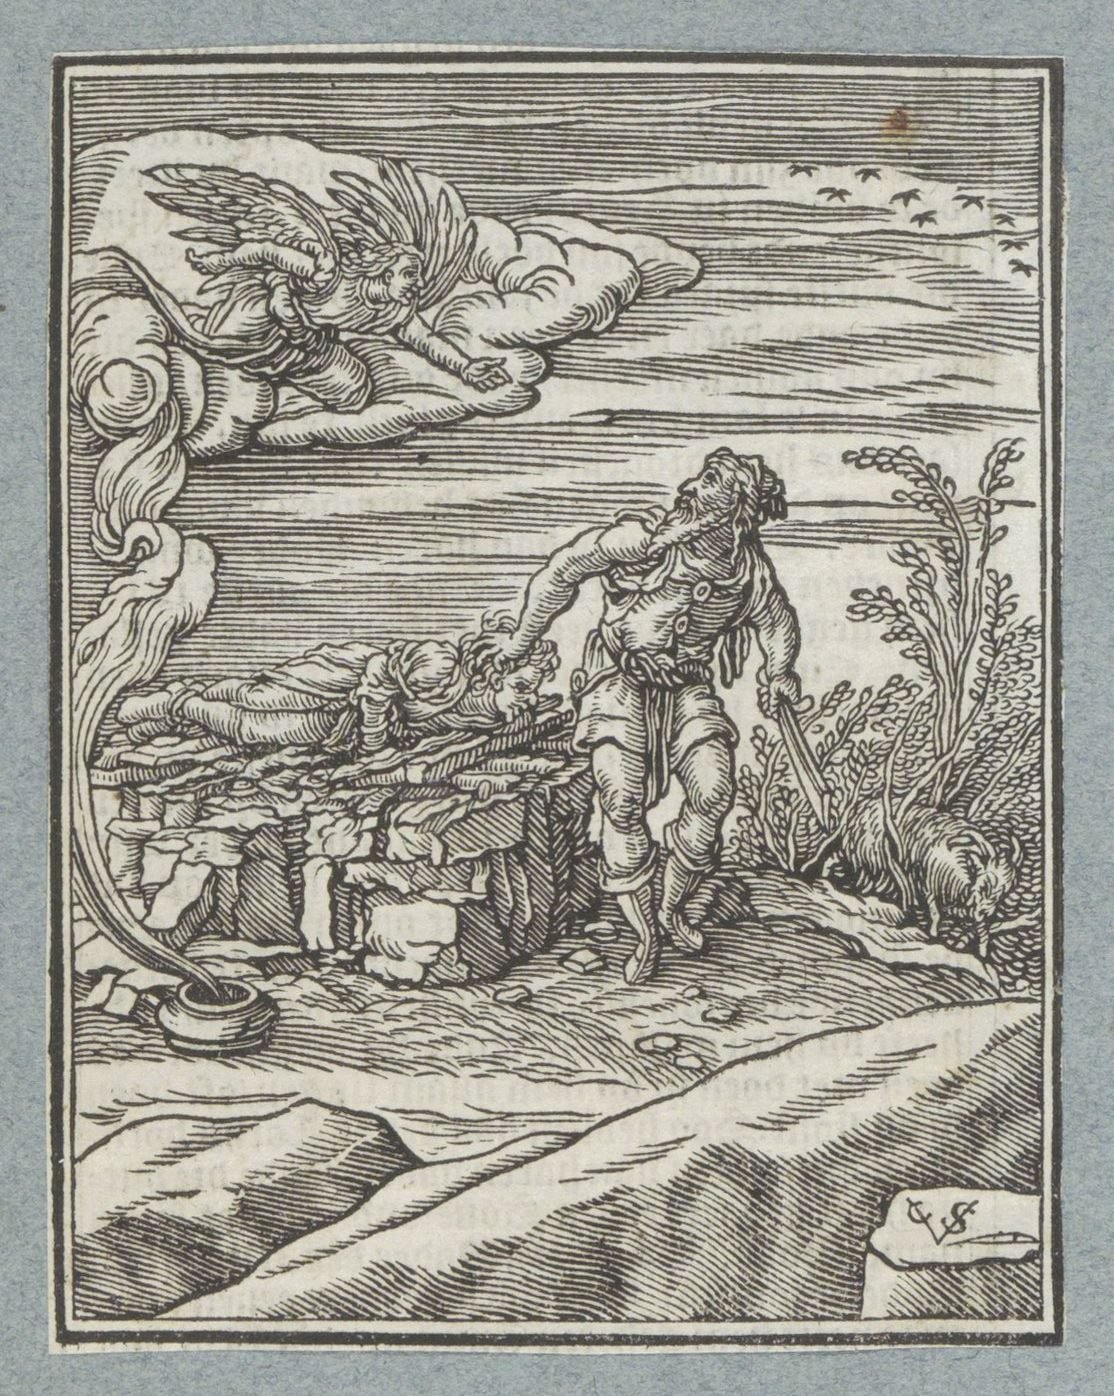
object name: book illustration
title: Offer van Abraham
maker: pieter jacobsz. paets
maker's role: publisher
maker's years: 1587-1667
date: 1645-1646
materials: paper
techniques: letterpress printing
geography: amsterdam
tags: abraham picks up the knife to kill isaac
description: De prent werd gemaakt voor de uitgaven van P.J. Paets uit Amsterdam. Ze komt in ieder geval voor in: Bibels Tresoor ofte der zielen lusthof. Amsterdam, P.J. Paets, 1646. Mogelijk ook in: Historien ende Prophetien. [Amsterdam], P.J. Paets, 1645.